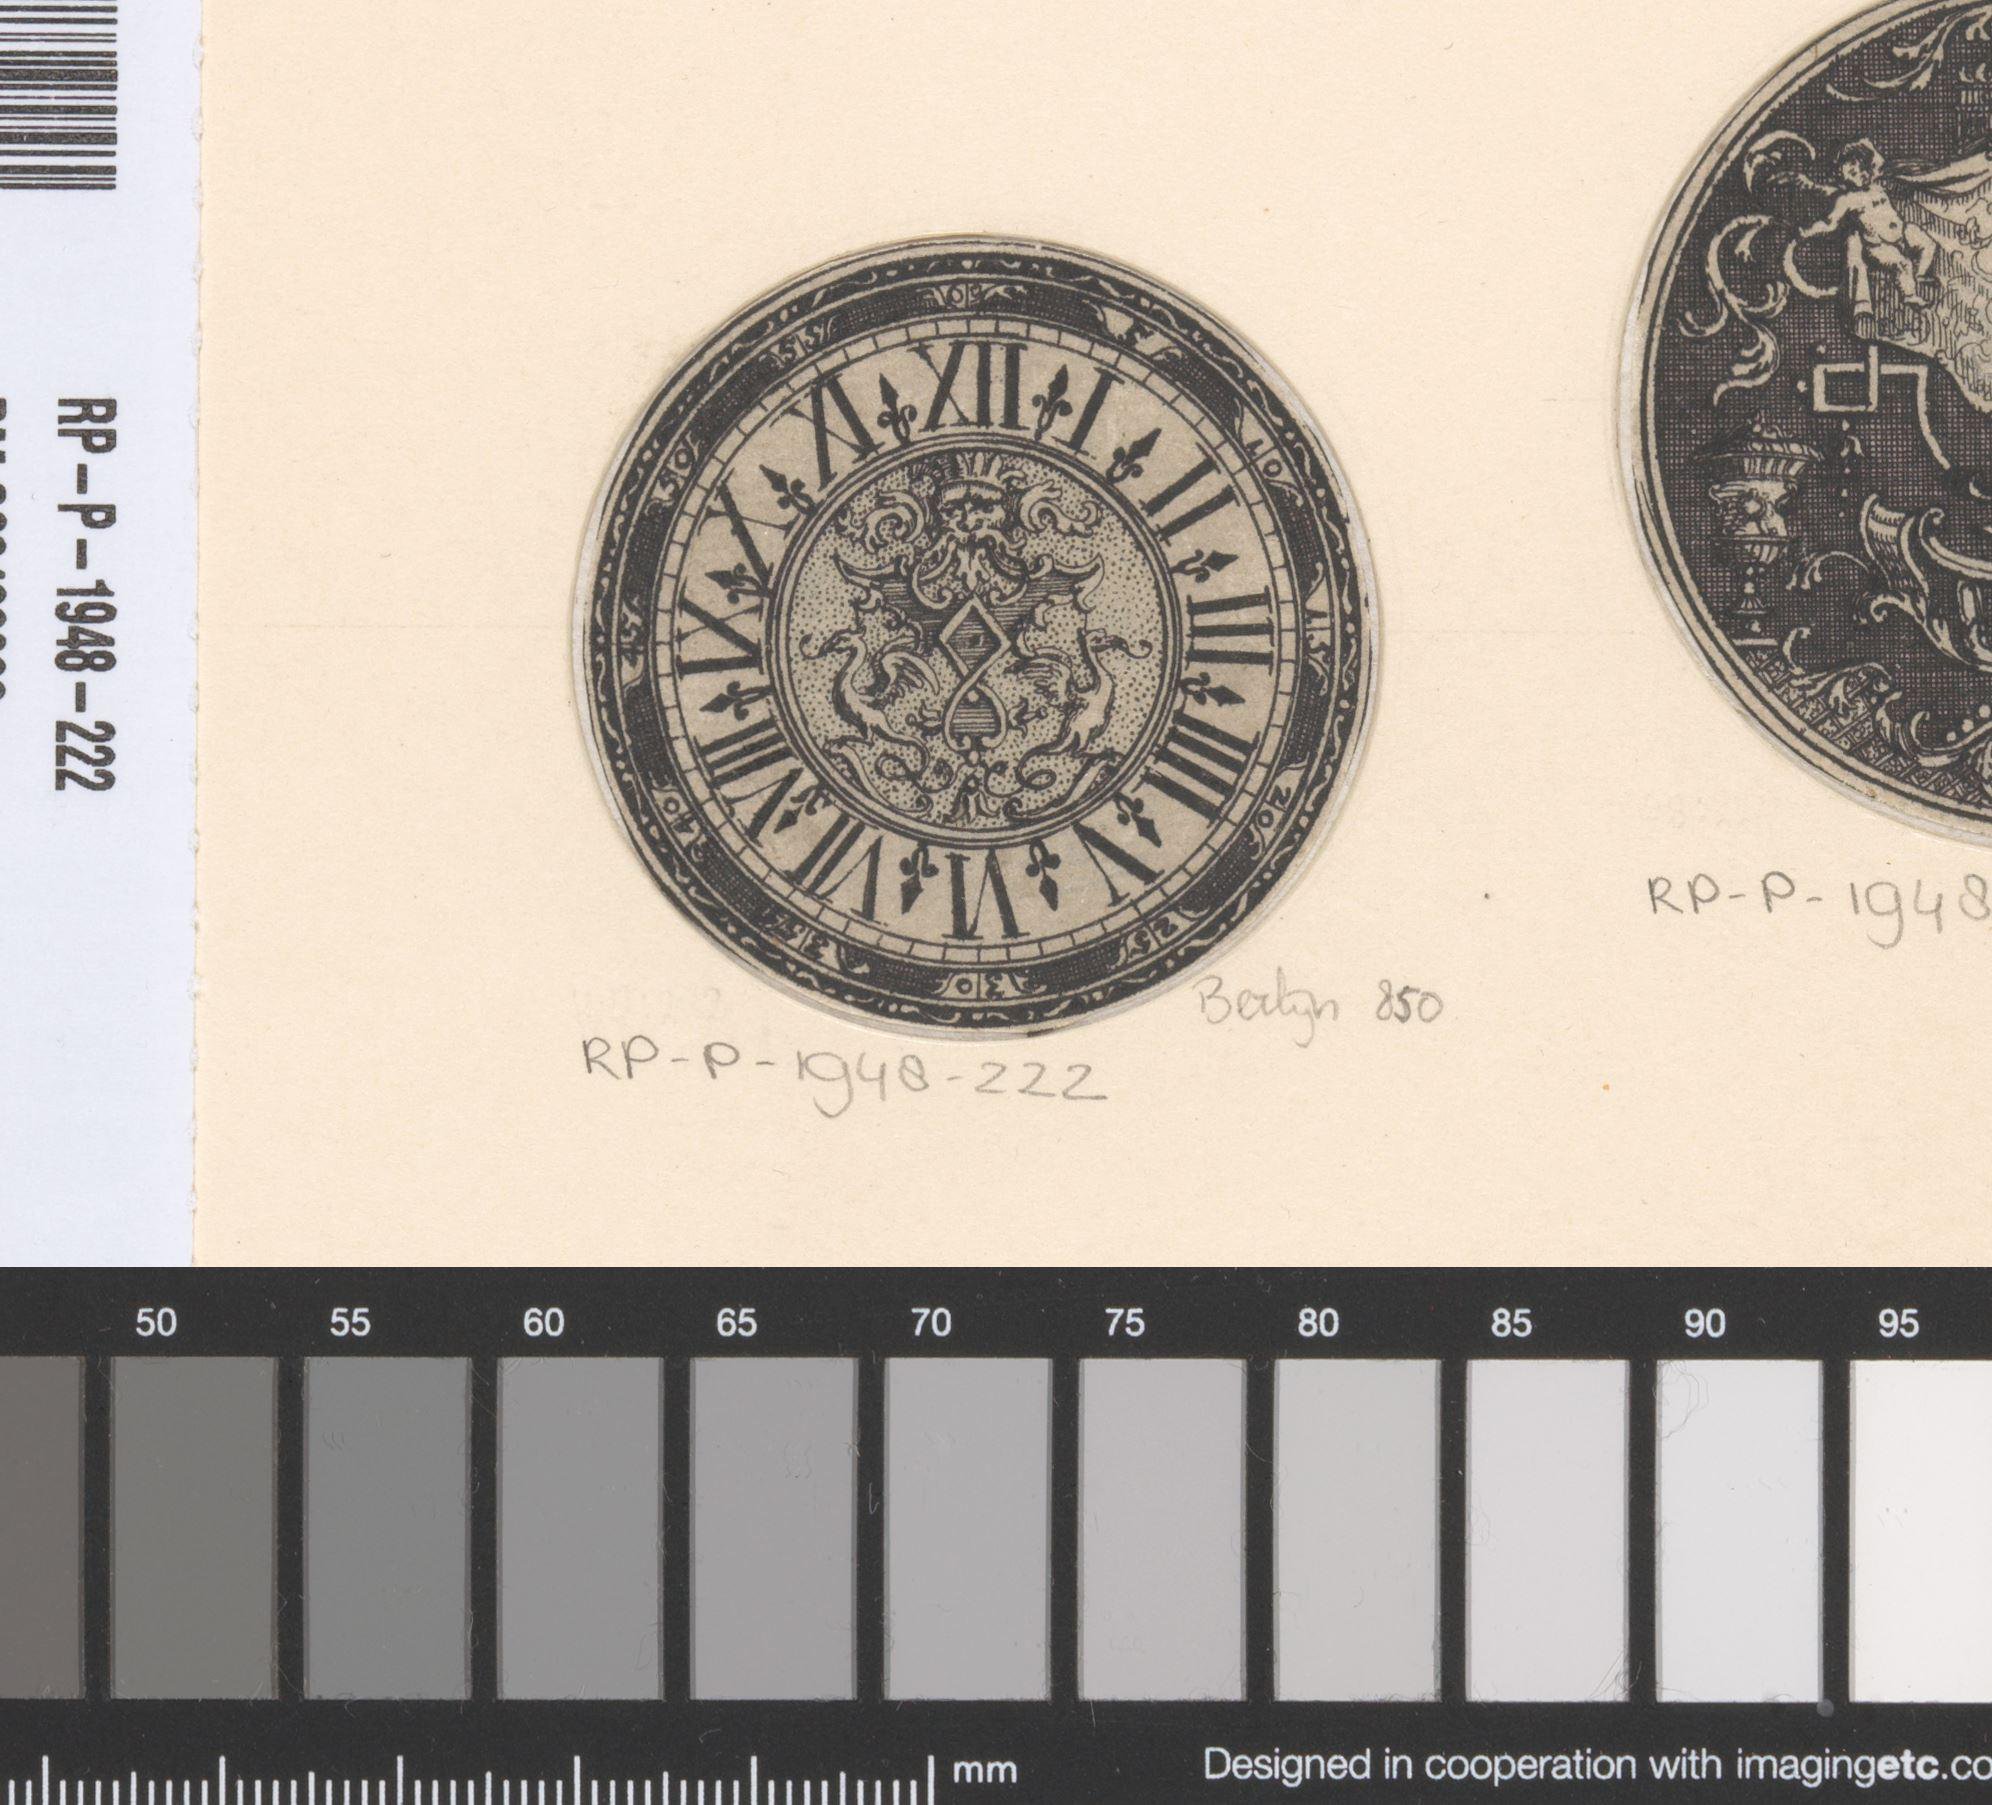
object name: print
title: Wijzerplaat met griffioenen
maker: Anonymous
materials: paper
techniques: etching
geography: paris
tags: griffin (lion/eagle); 'griffo' (ripa), clock, mask, mascaron ~ ornament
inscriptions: collector's mark: Lugt 1403b, collector's mark: Lugt 2228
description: Een ronde wijzerplaat met in het midden een masker en twee griffioenen.